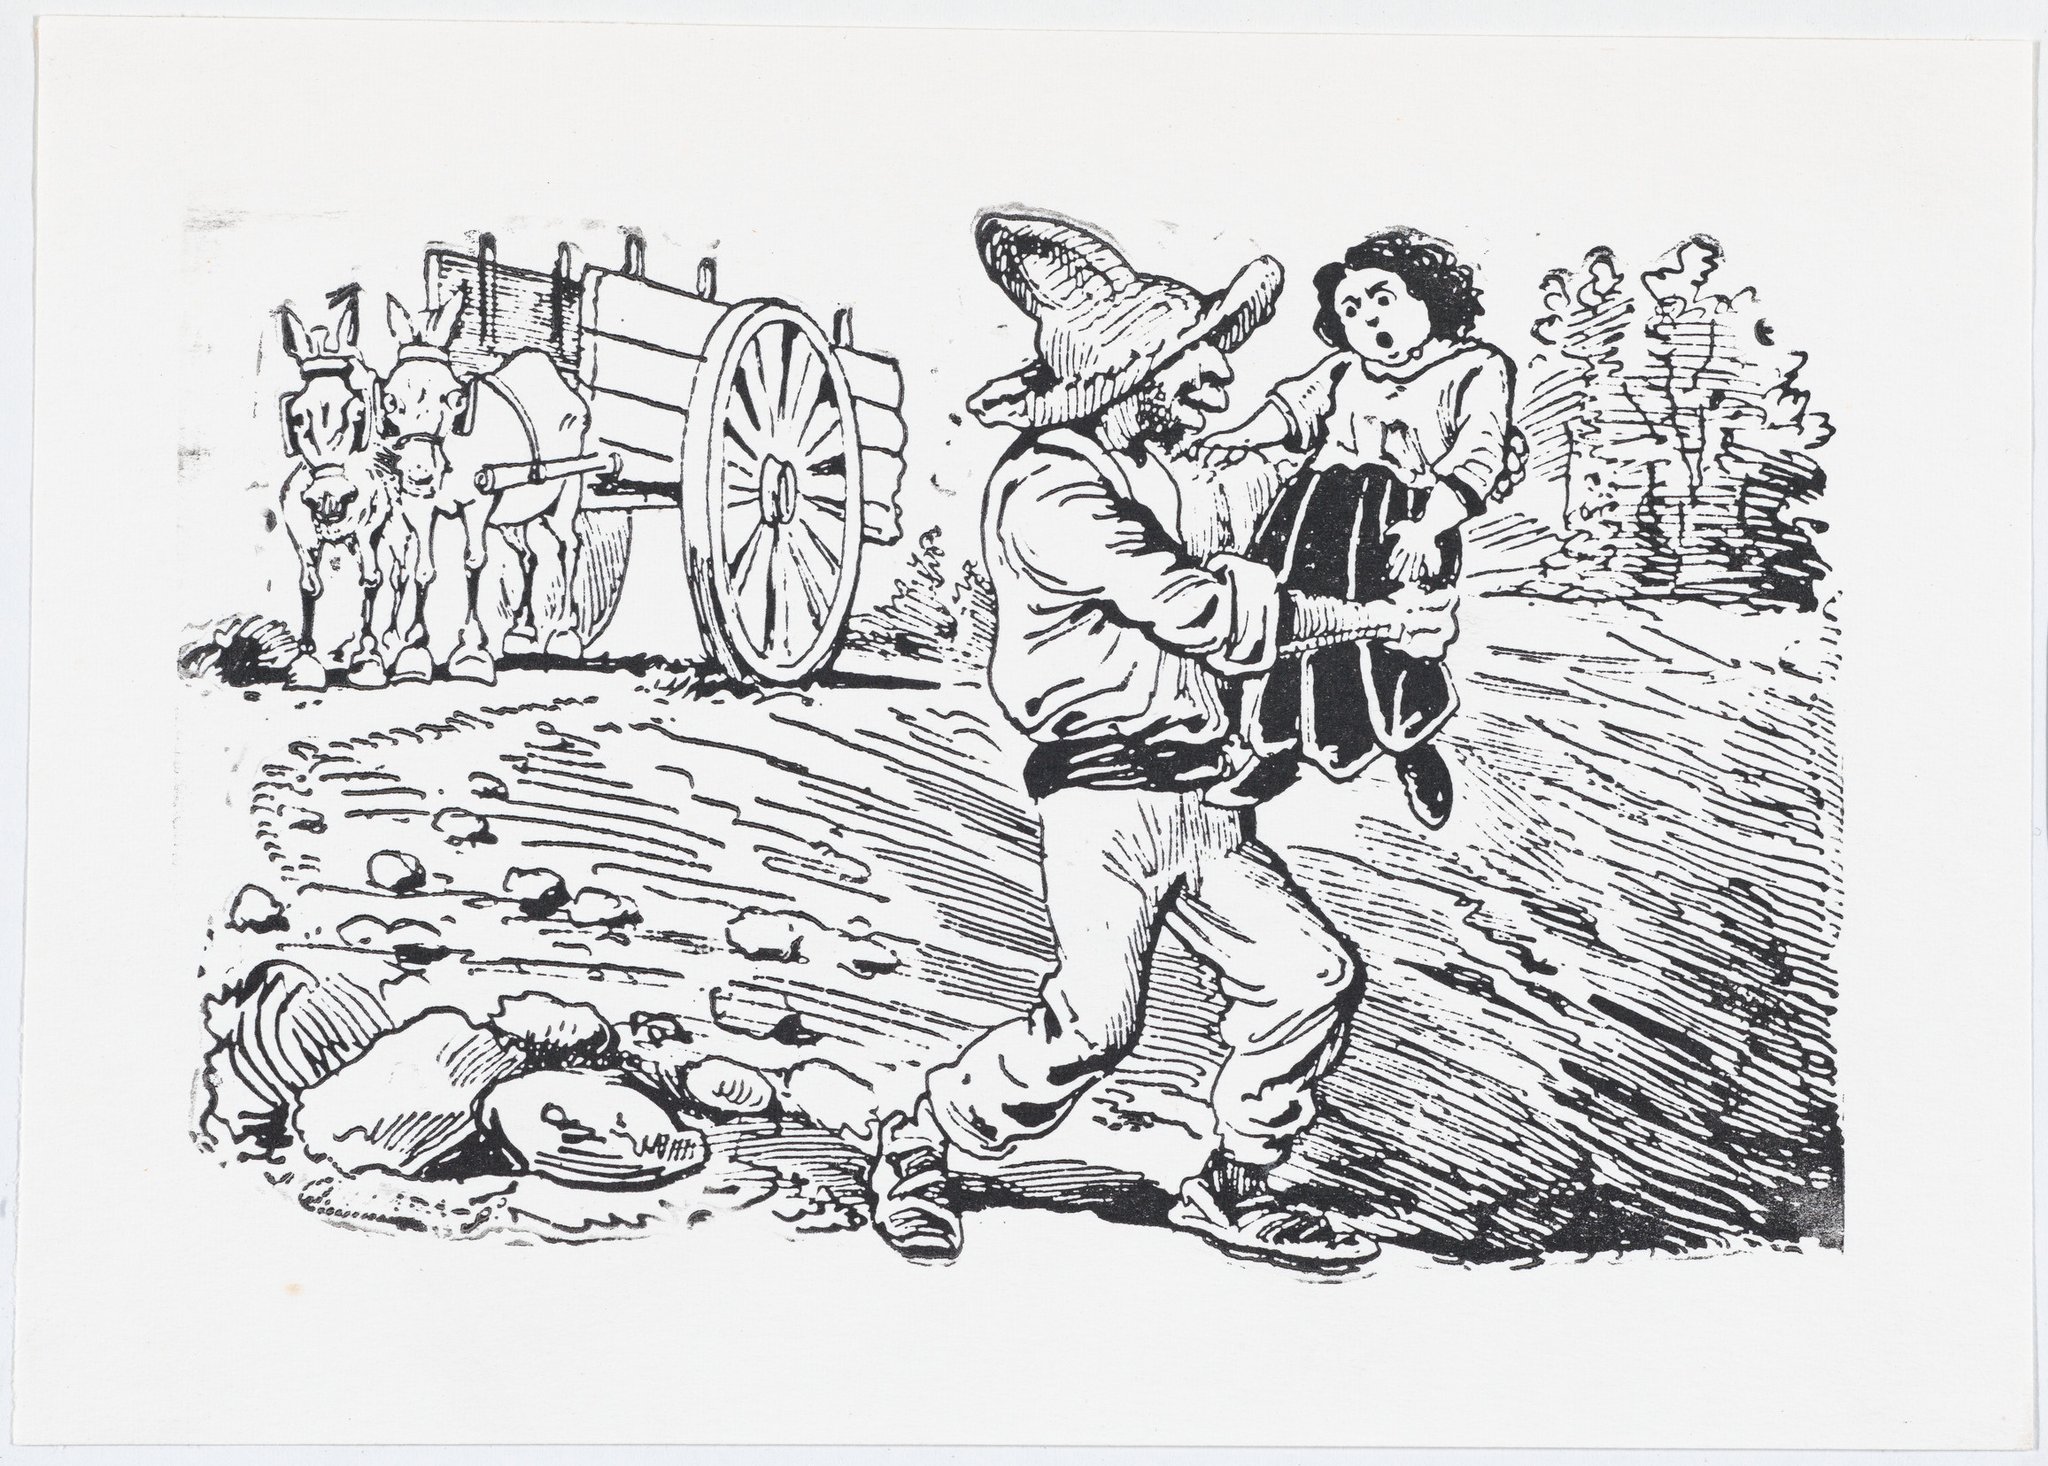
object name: print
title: A man in a hat kidnapping a child from a broadside entitled 'Los roba-chicos en acción'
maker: josé guadalupe posada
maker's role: artist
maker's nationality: mexican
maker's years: 1852-1913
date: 1880-1910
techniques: lithography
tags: children,men,donkeys,wagons